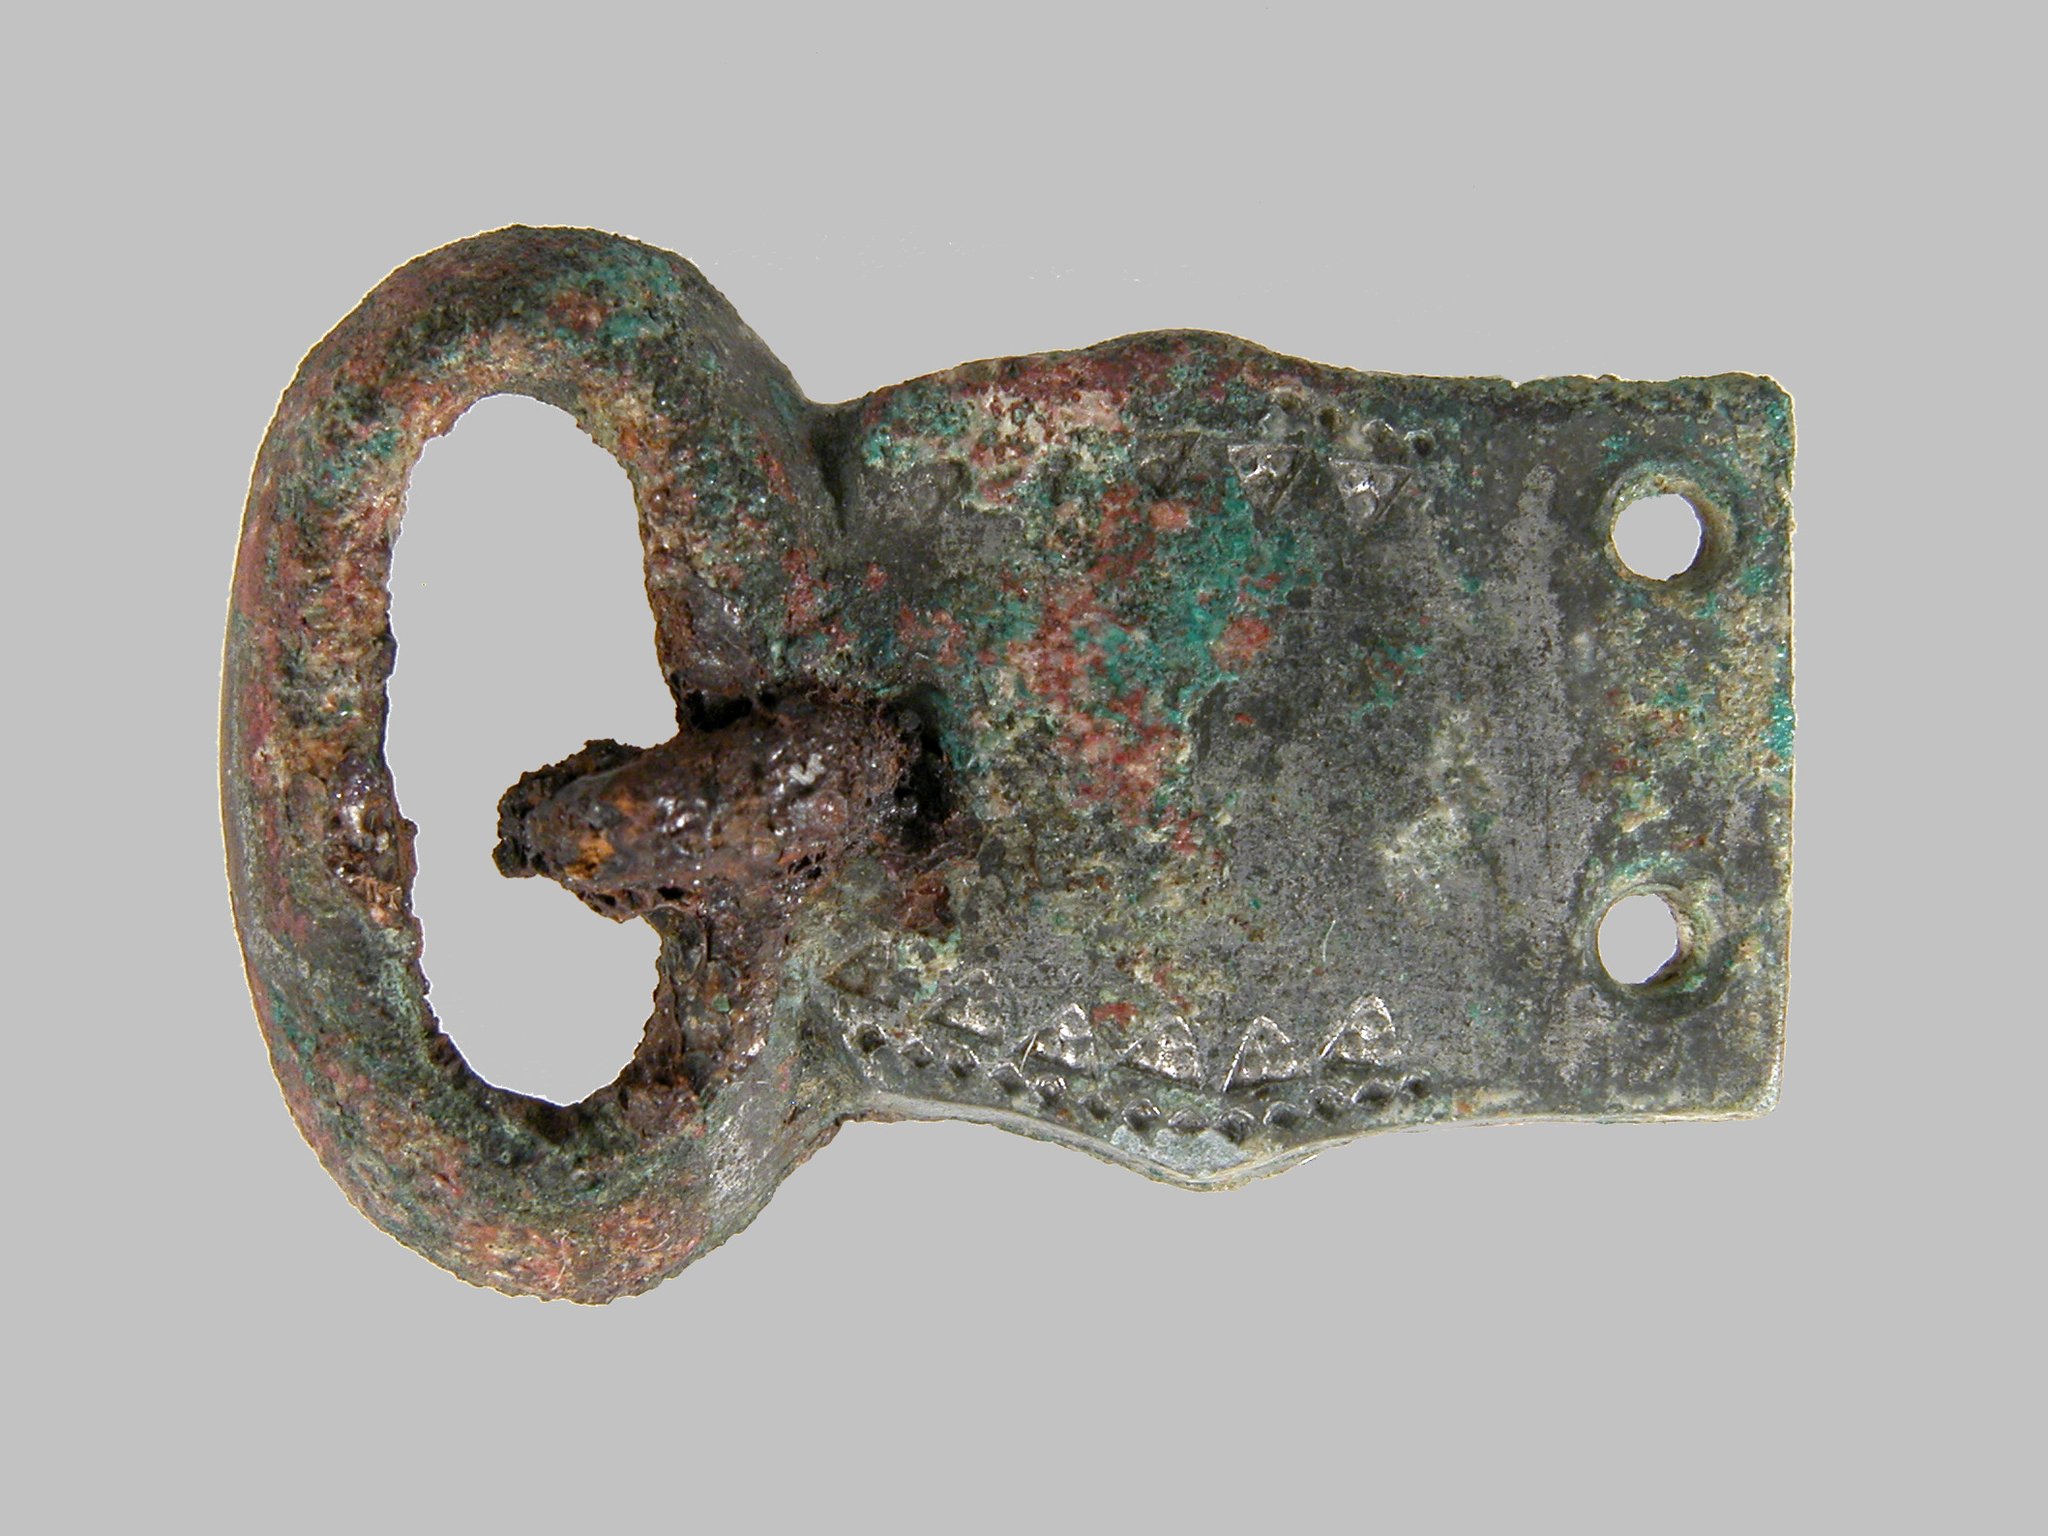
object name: buckle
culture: frankish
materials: copper alloy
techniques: silvered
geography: germany